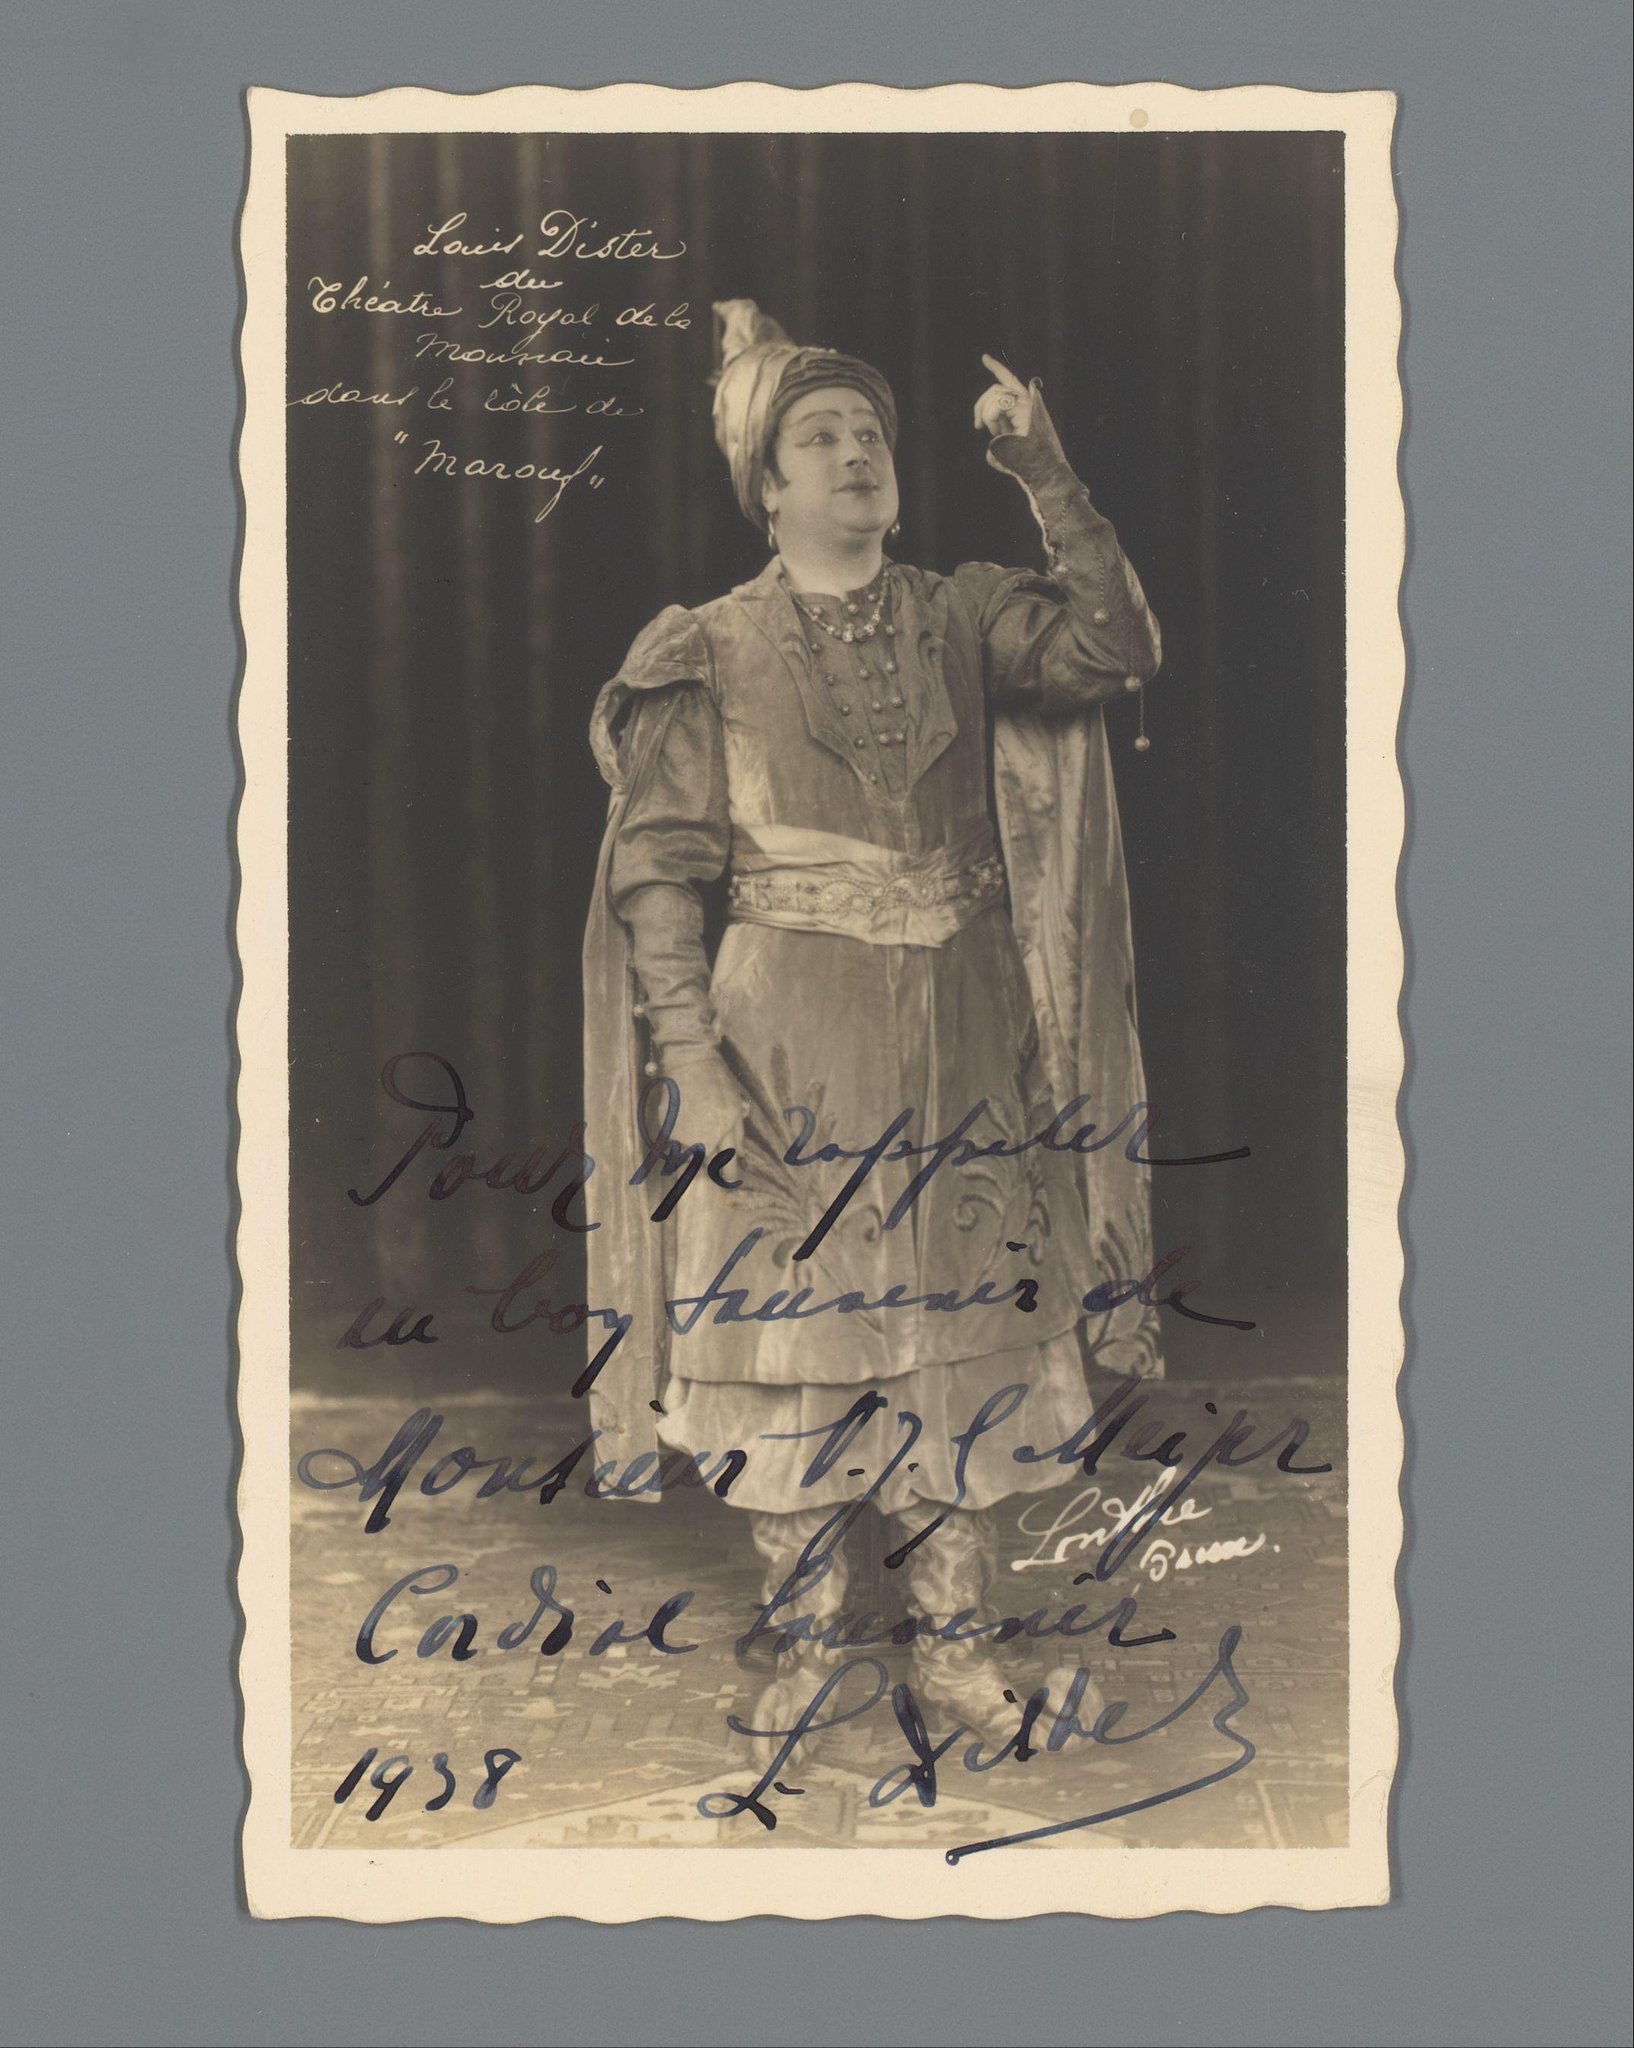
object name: photograph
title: Portret van de tenor Louis Dister, als Marouf in de opera Marouf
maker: rené lonthie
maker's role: fotograaf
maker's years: 1889-1959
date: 1938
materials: paper, ink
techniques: gelatin silver print, pen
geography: brussels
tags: liège, historical persons, portrait of opera-singer, brussels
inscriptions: stamp: ‘Commission d'Assistance publique/ Comblain-Fairon’, inscription: ‘Louis Dister/ du Théatre Royal de la/ Monnaie/ dans le rôle de/ Marouf/ Lonthie/ Brux.’, inscription: ‘Pour me rappeler/ en bon souvenir de/ Monsieur O.J. Meijer/ Cordial Souvenir/ L. Dister/ 1938’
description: Gesigneerd en met opdracht aan Nico Meijer, 1938.